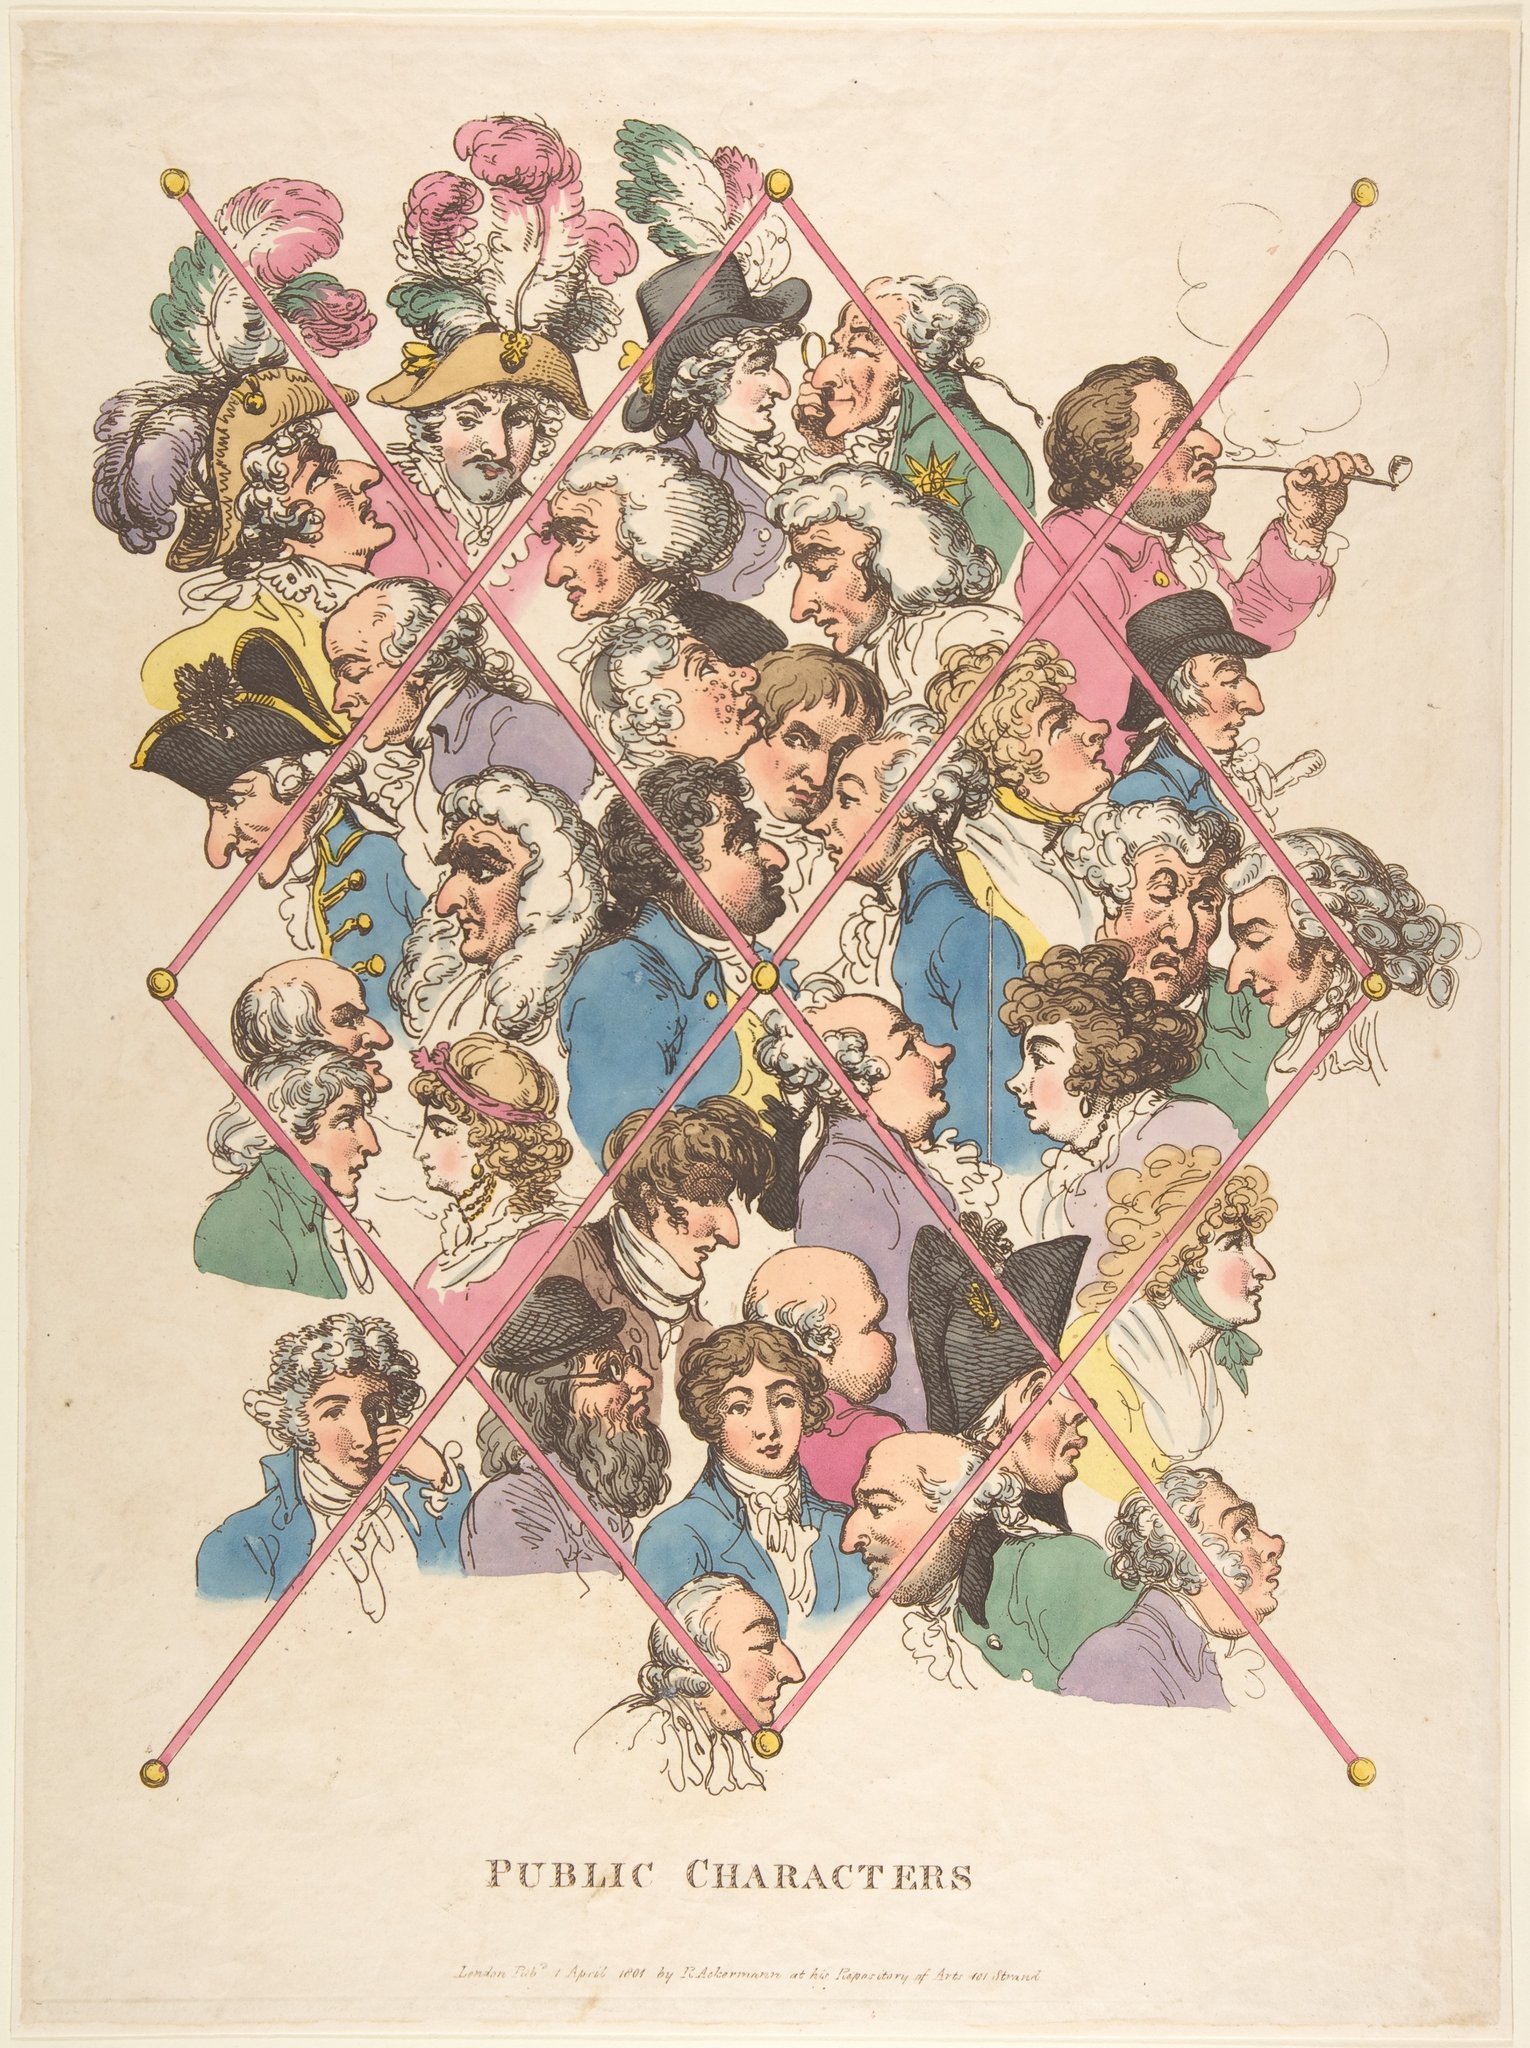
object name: print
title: Public Characters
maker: thomas rowlandson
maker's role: artist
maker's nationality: british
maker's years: 1757-1827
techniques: etching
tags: men,women,caricature